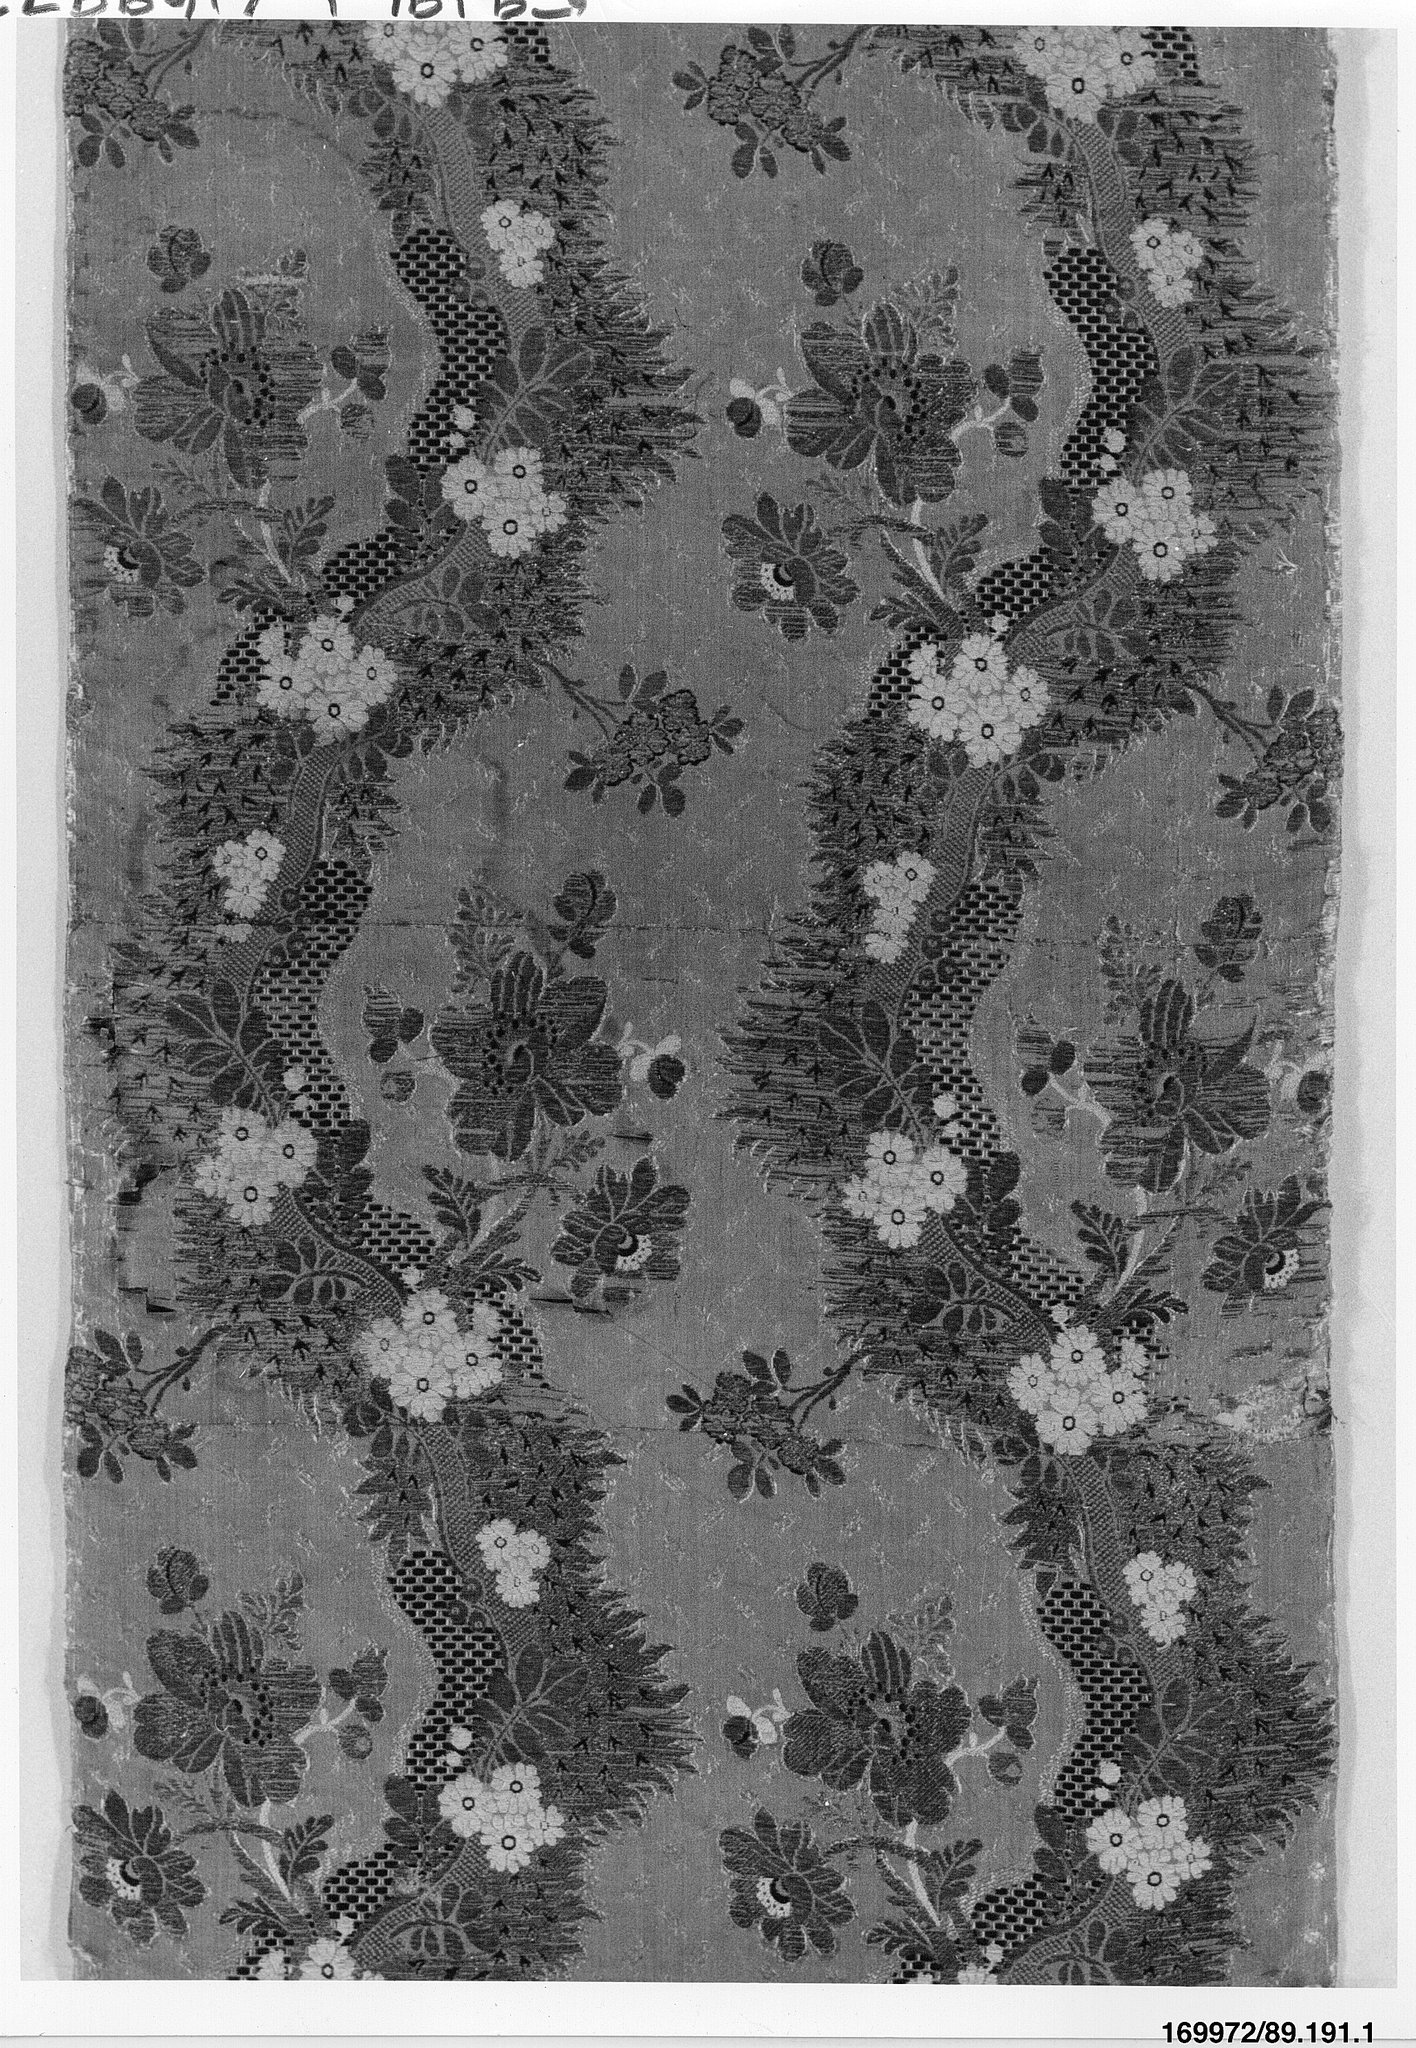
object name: piece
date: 1760-1770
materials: silk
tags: flowers